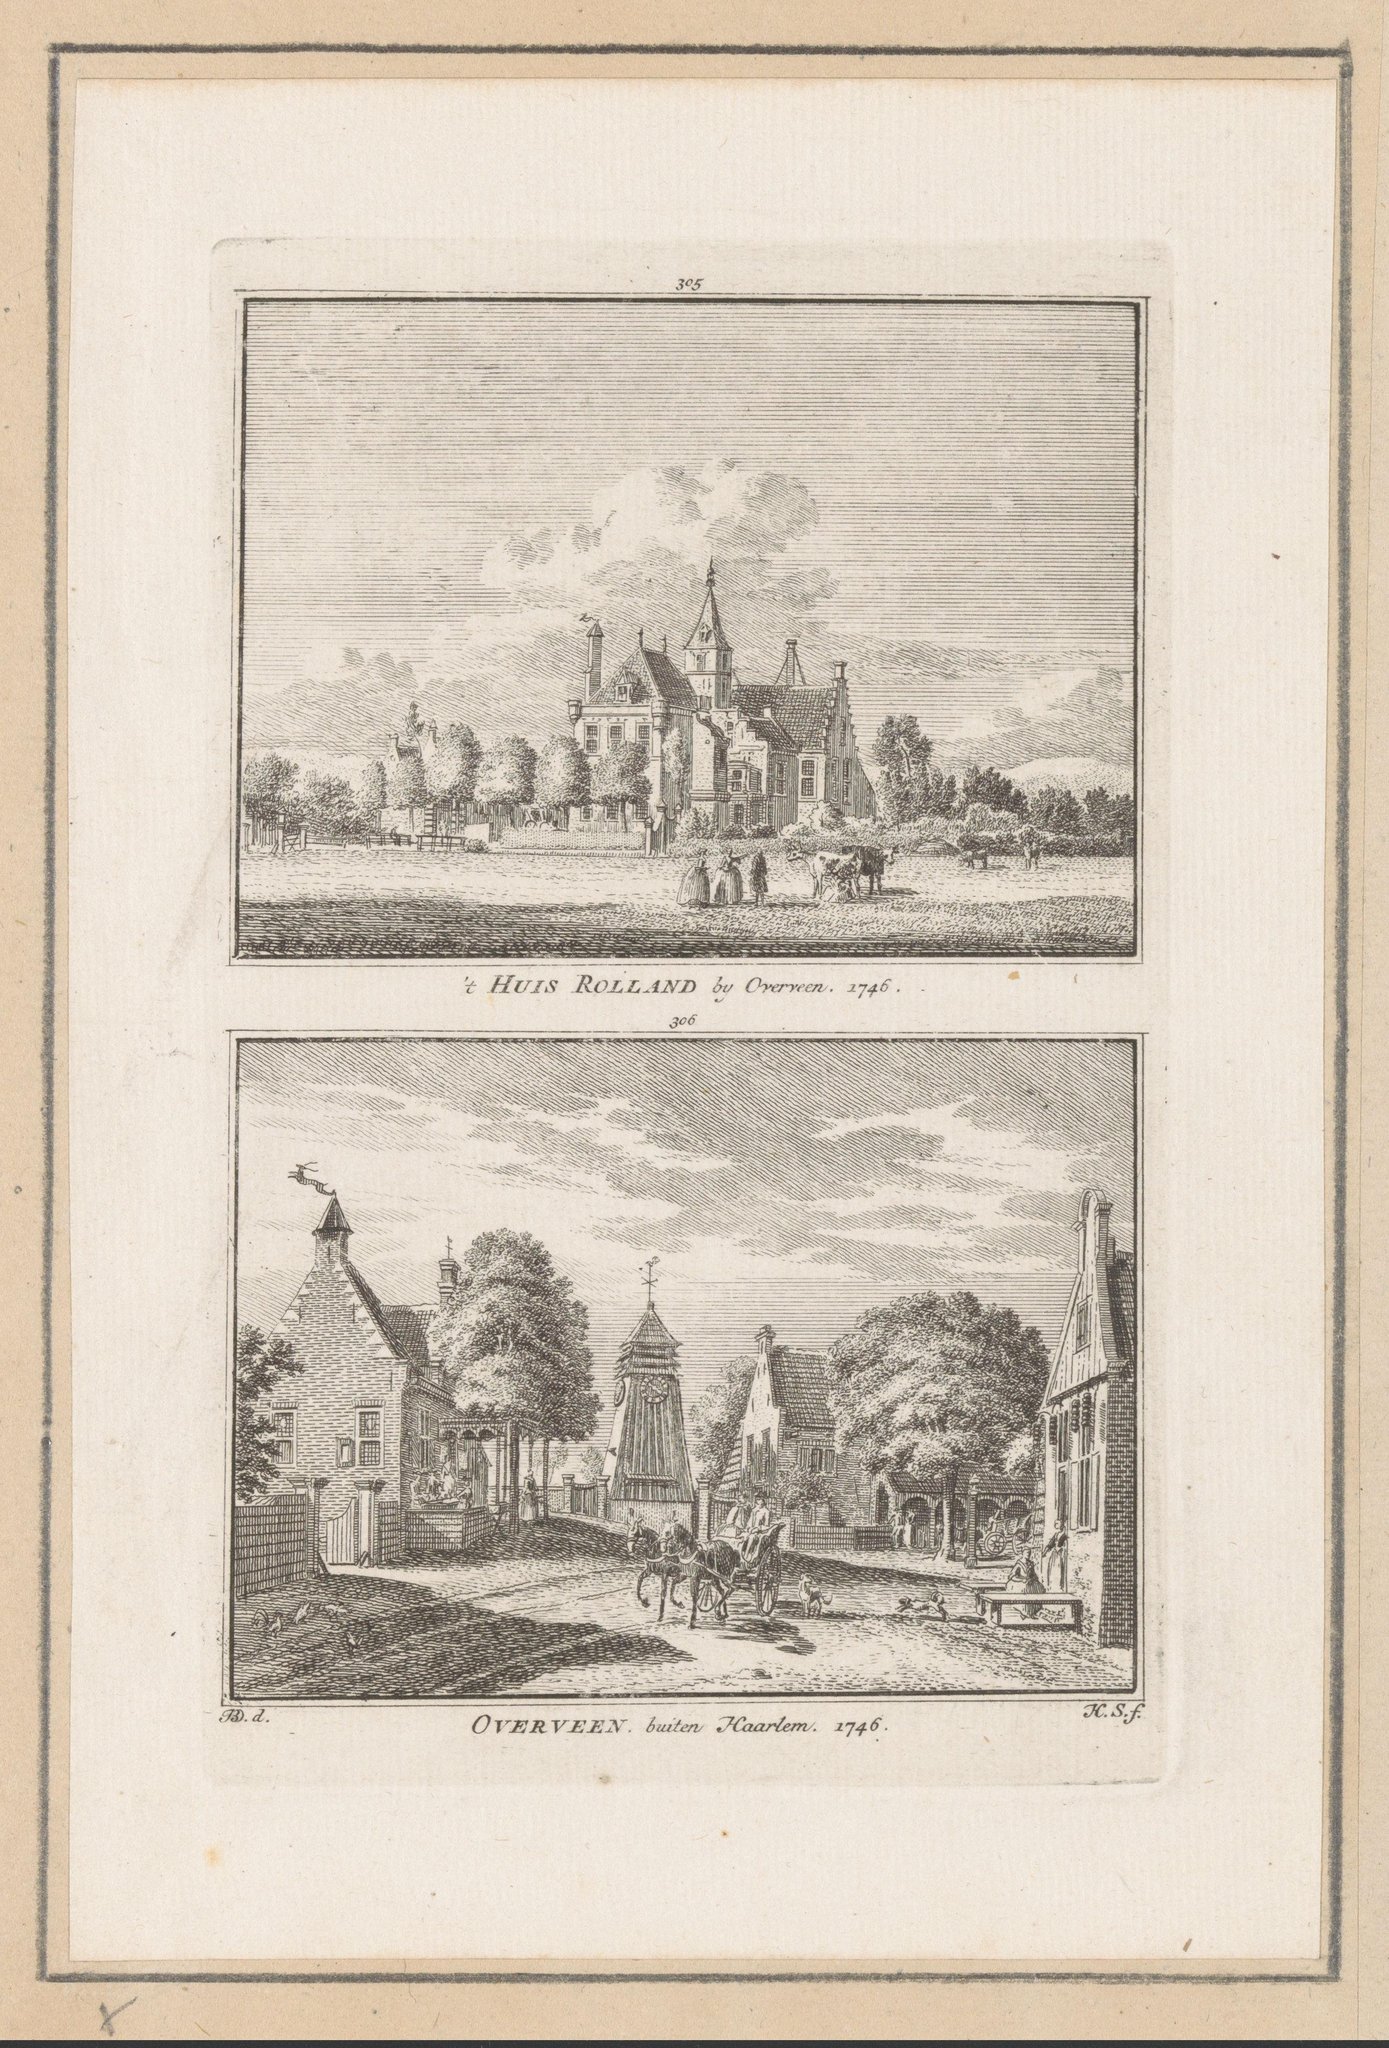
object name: print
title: Gezicht op Huis Rolland en gezicht op Overveen, 1746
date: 1752-1792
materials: paper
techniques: engraving, etching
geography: haarlem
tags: prospect of village, silhouette of village, castle, public road in village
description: Prent ook gebruikt in: Het verheerlykt Nederland of kabinet van hedendaagsche gezigten van steden, dorpen (…). 9 delen. Amsterdam: Isaak Tirion en weduwe Isaak Tirion, 1745-1774, dl. 4 (1752), ill. 305 en 306. Of in: Nederlandsche tafereelen; of eene keurige verzameling van negen honderd fraaije gezigten van steden, dorpen, sloten, oudheden (….). 9 delen. Amsterdam: Jan de Groot, 1792, dl. 4, ill. 305 en 306. Uit welke druk het huidige exemplaar precies komt is niet na te gaan.